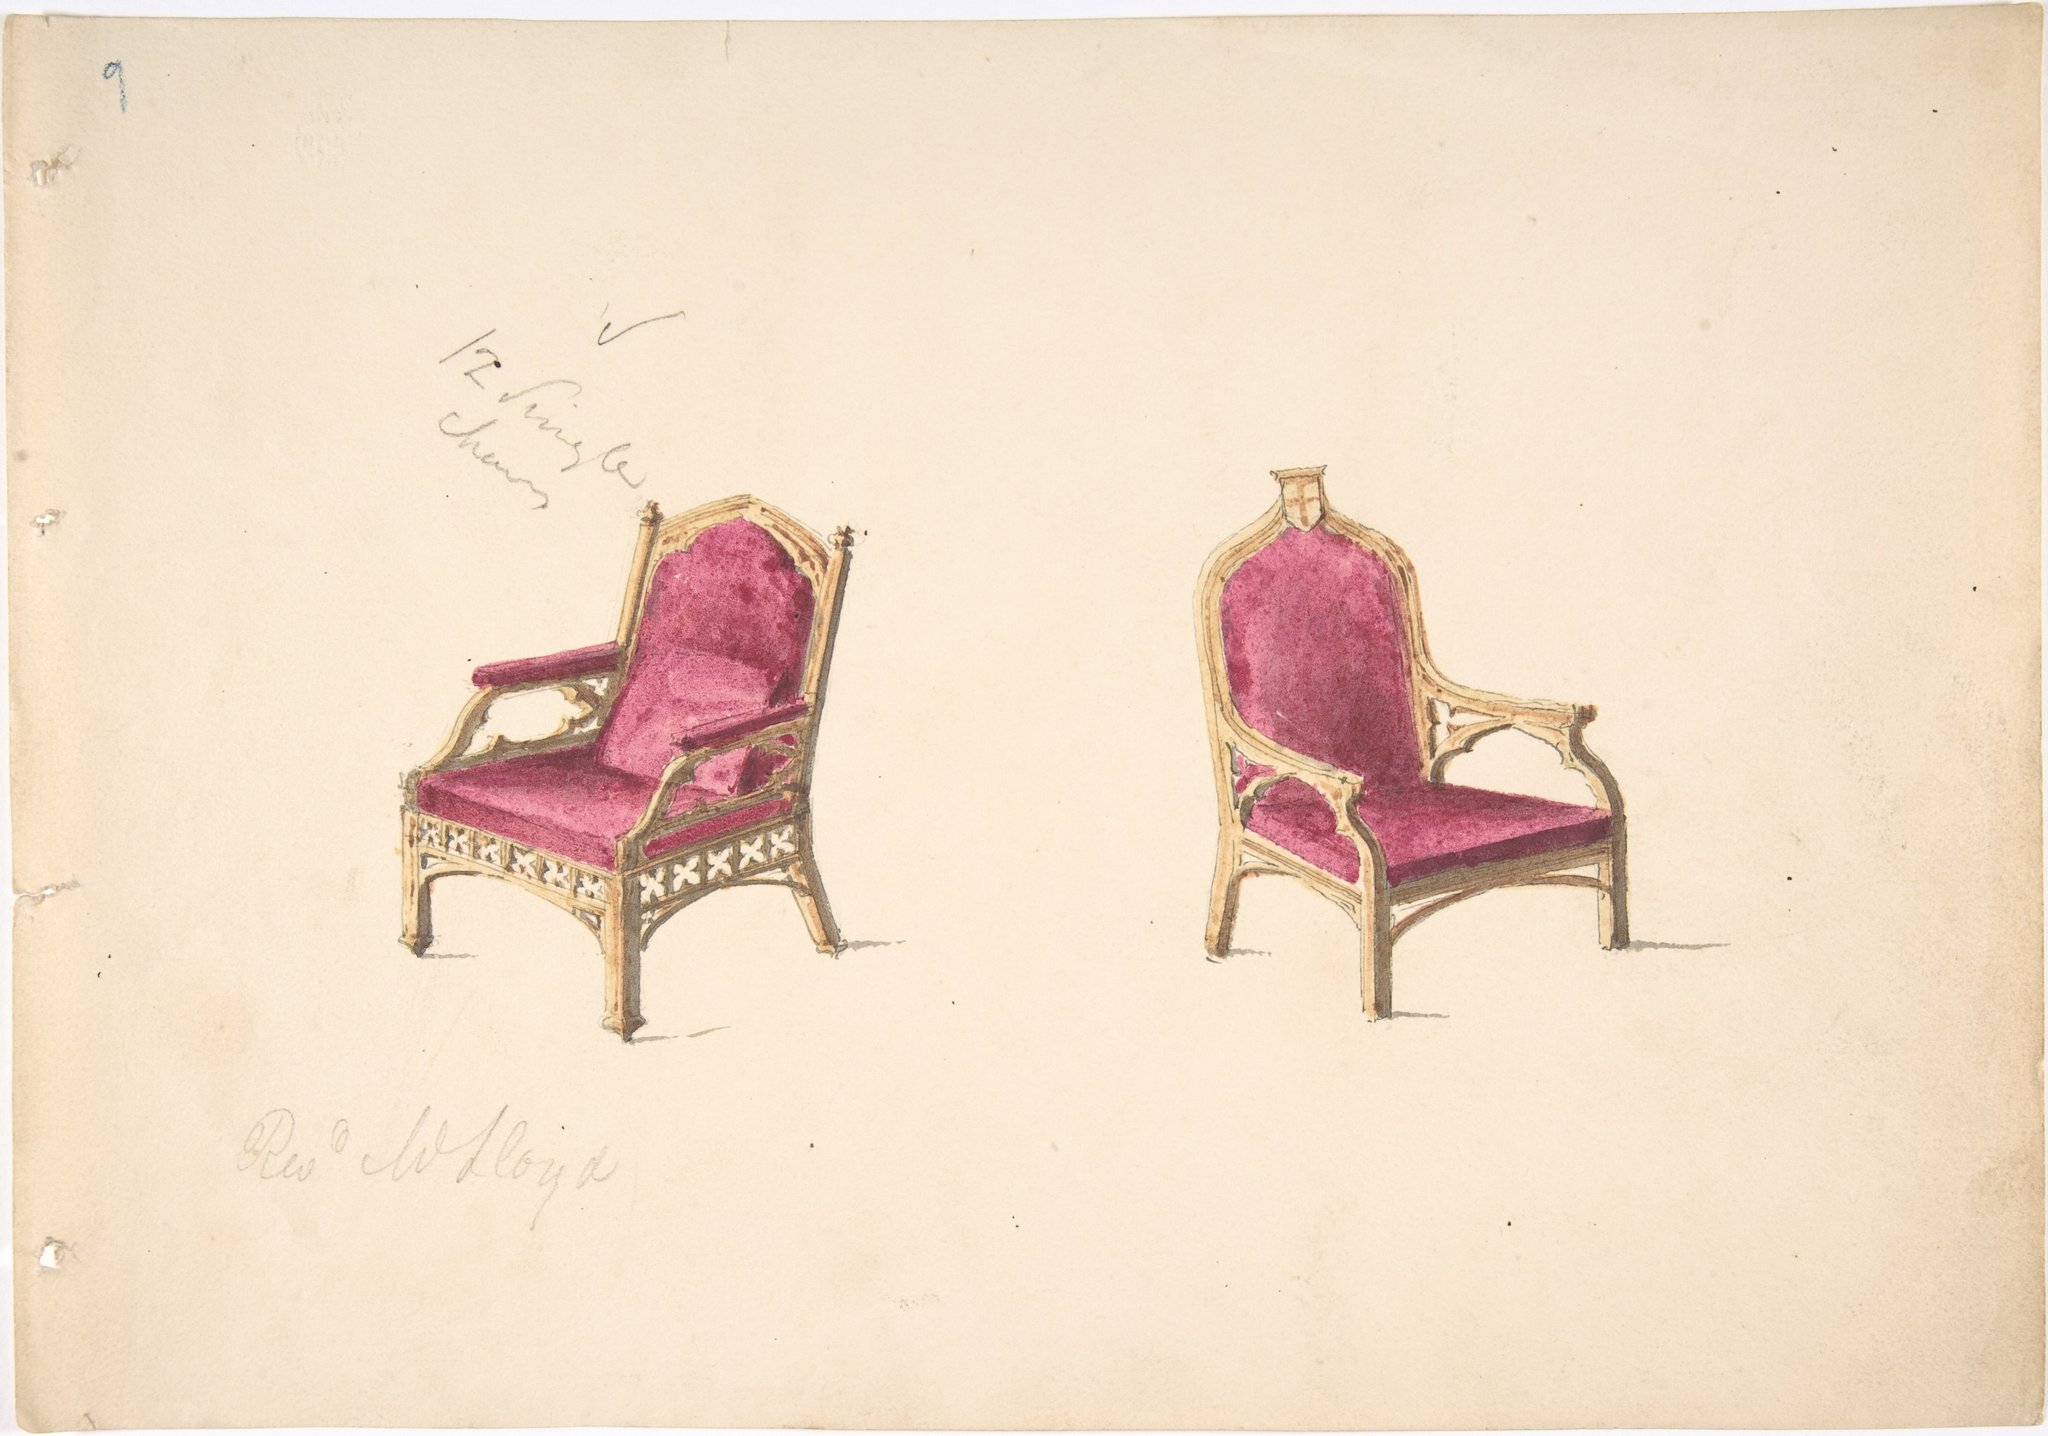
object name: drawing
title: Design for Two Medieval Style Armchairs for "Rev. W. Lloyd"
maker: anonymous, british, 19th century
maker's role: artist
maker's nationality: british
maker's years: 1800-1900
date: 1801-1833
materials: ink, watercolor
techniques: pen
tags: chairs